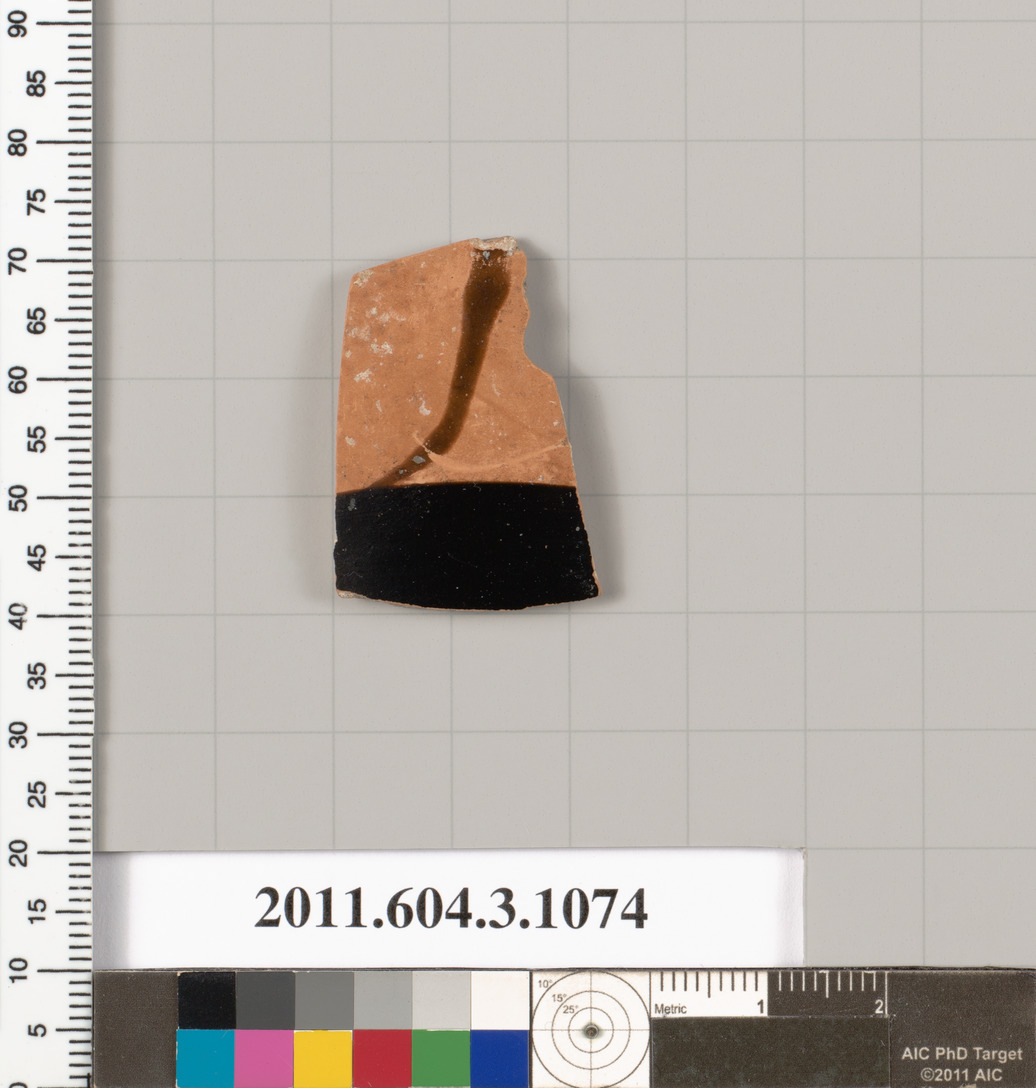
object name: mastoid fragment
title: Terracotta fragment of a mastoid (drinking cup with narrow base)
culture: greek, attic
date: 534-468 BCE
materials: terracotta